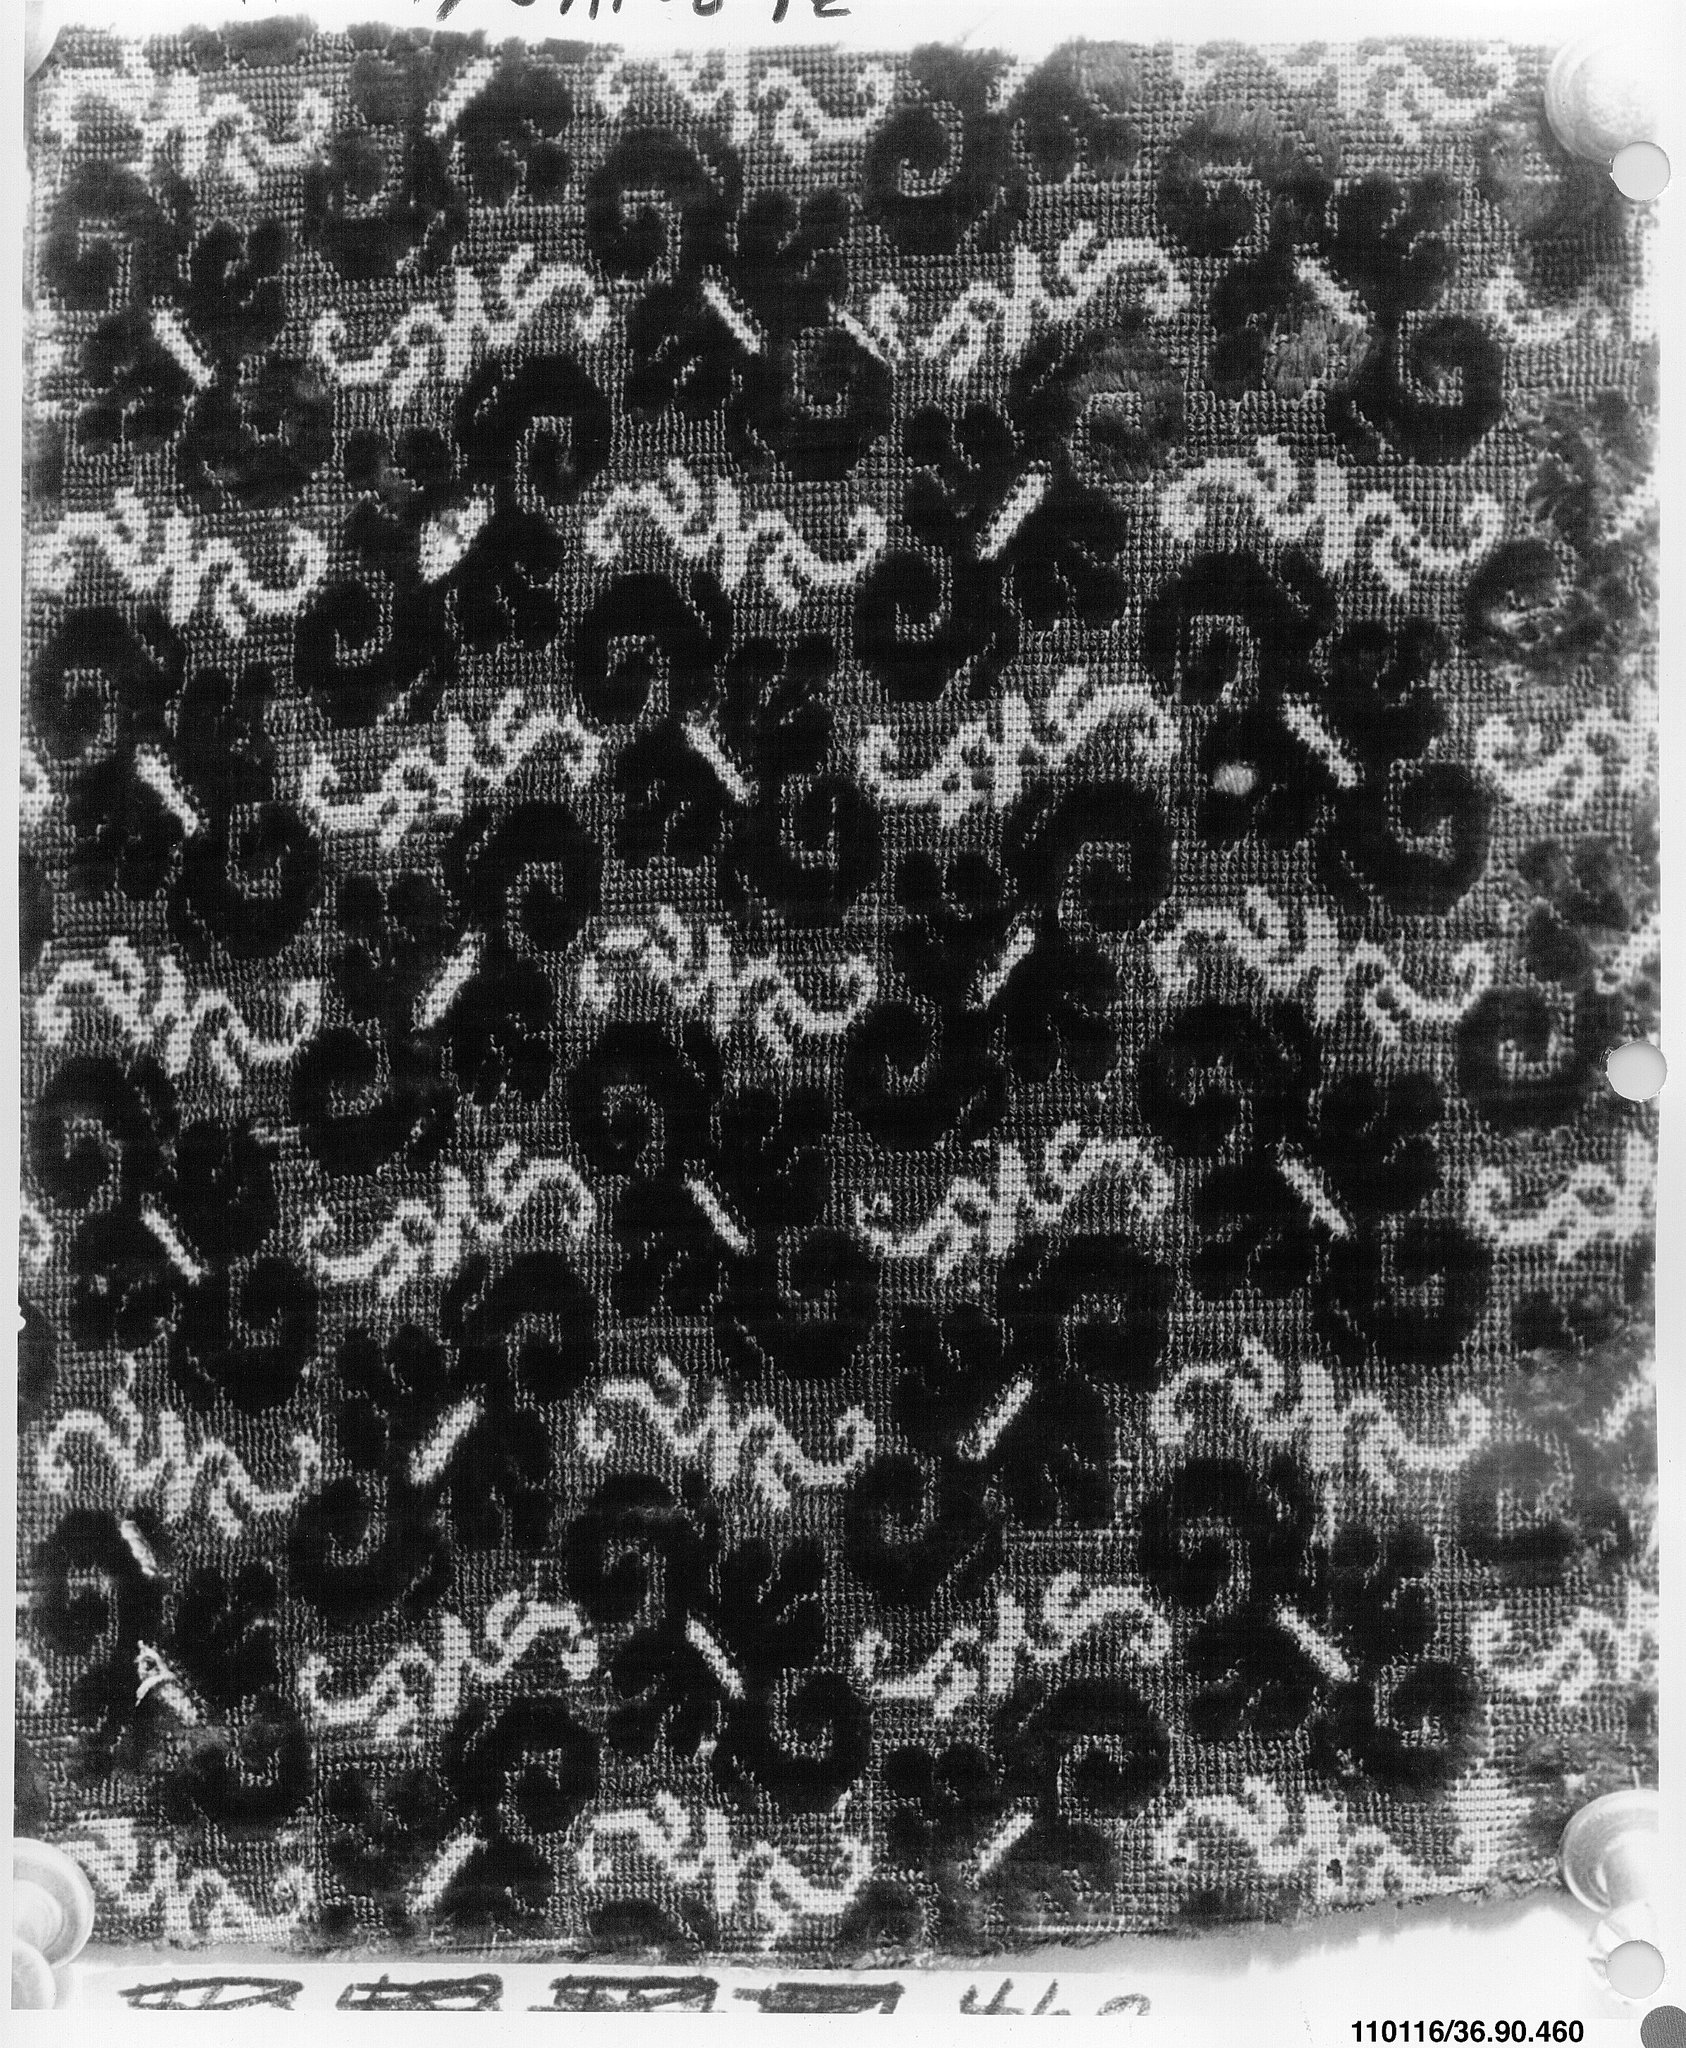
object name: piece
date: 1501-1700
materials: silk